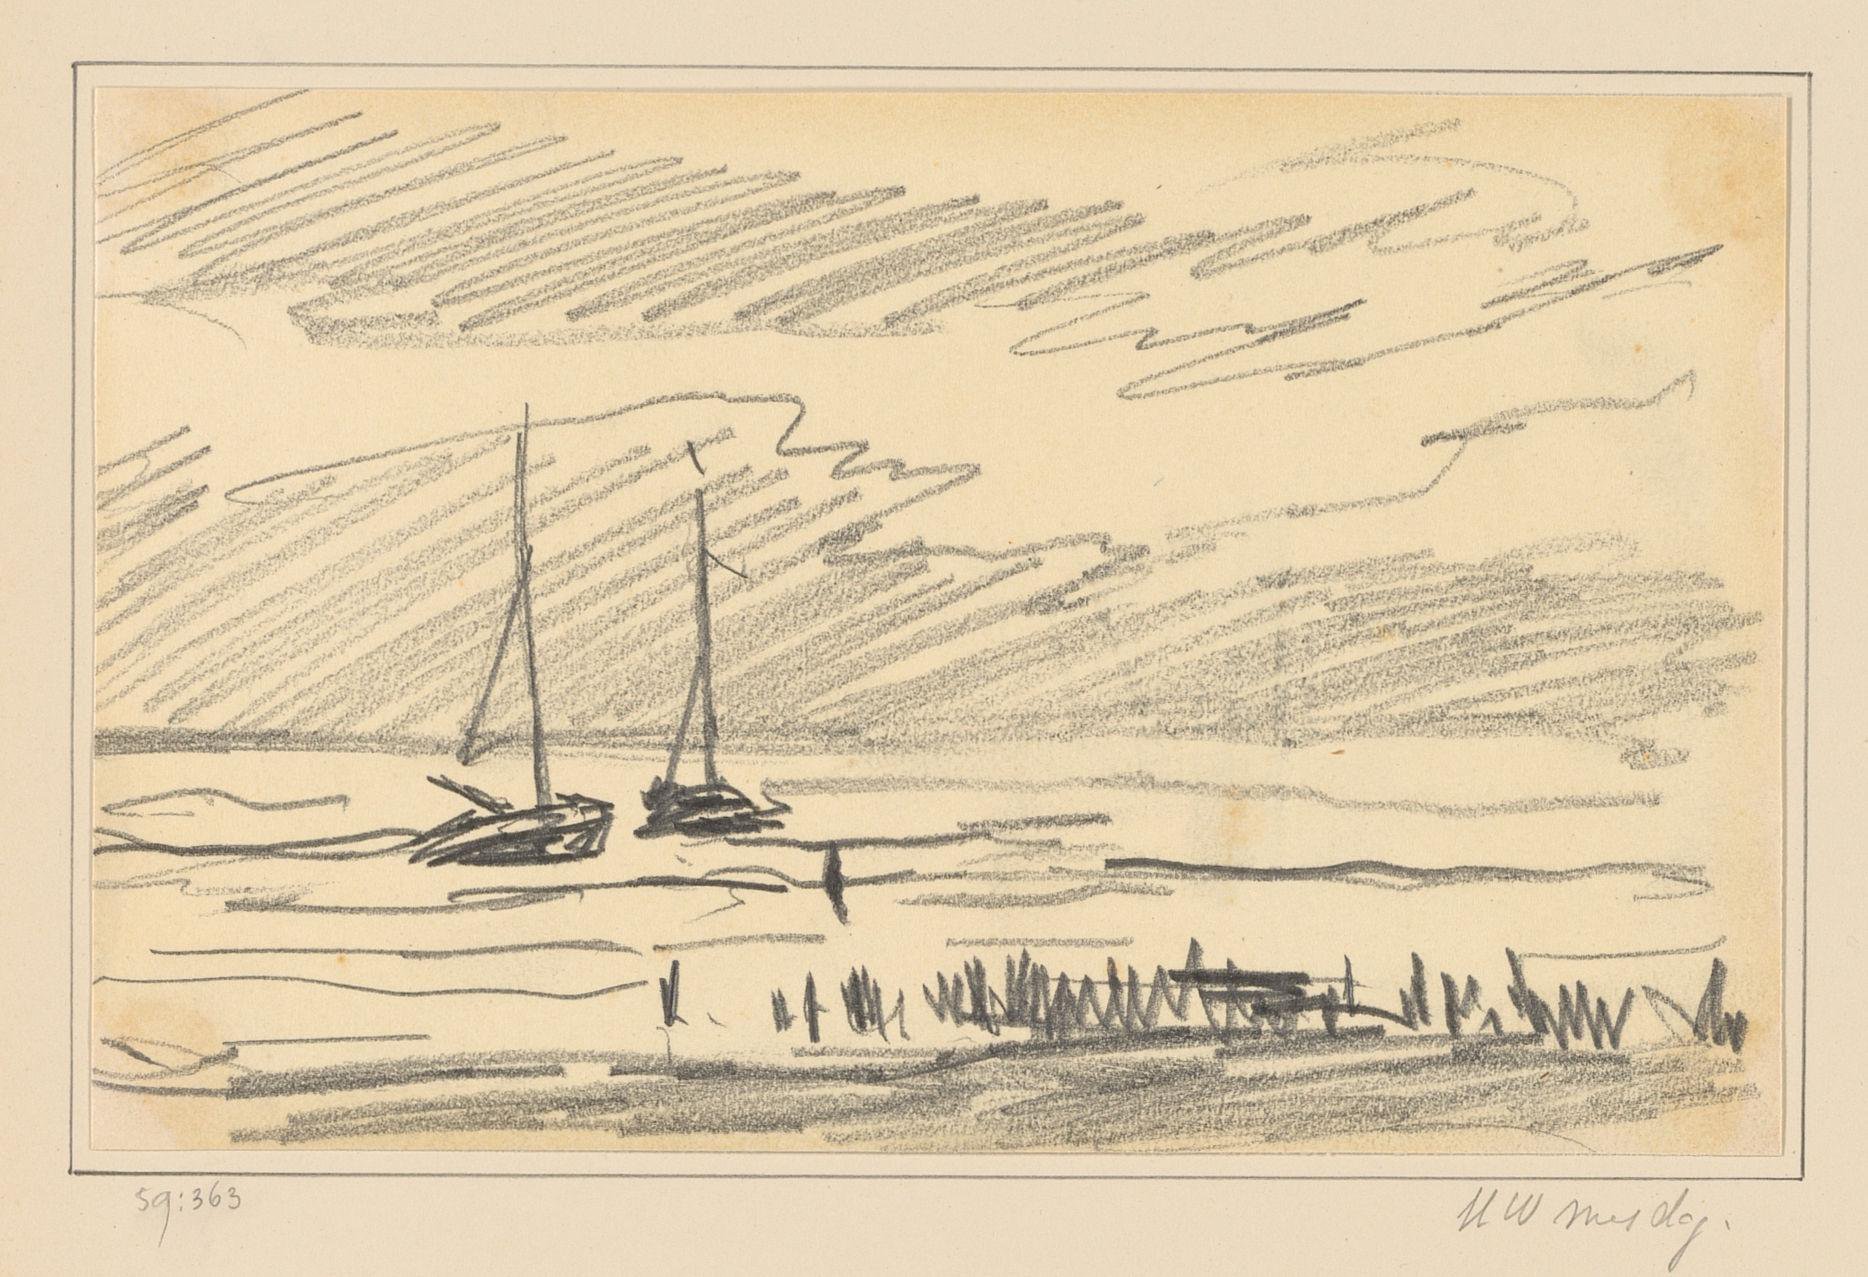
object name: drawing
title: Zeegezicht met boten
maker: hendrik willem mesdag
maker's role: draughtsman, painter, print maker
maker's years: 1831-1915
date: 1831-1915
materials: paper, pencil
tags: ships (in general), sea (seascape)